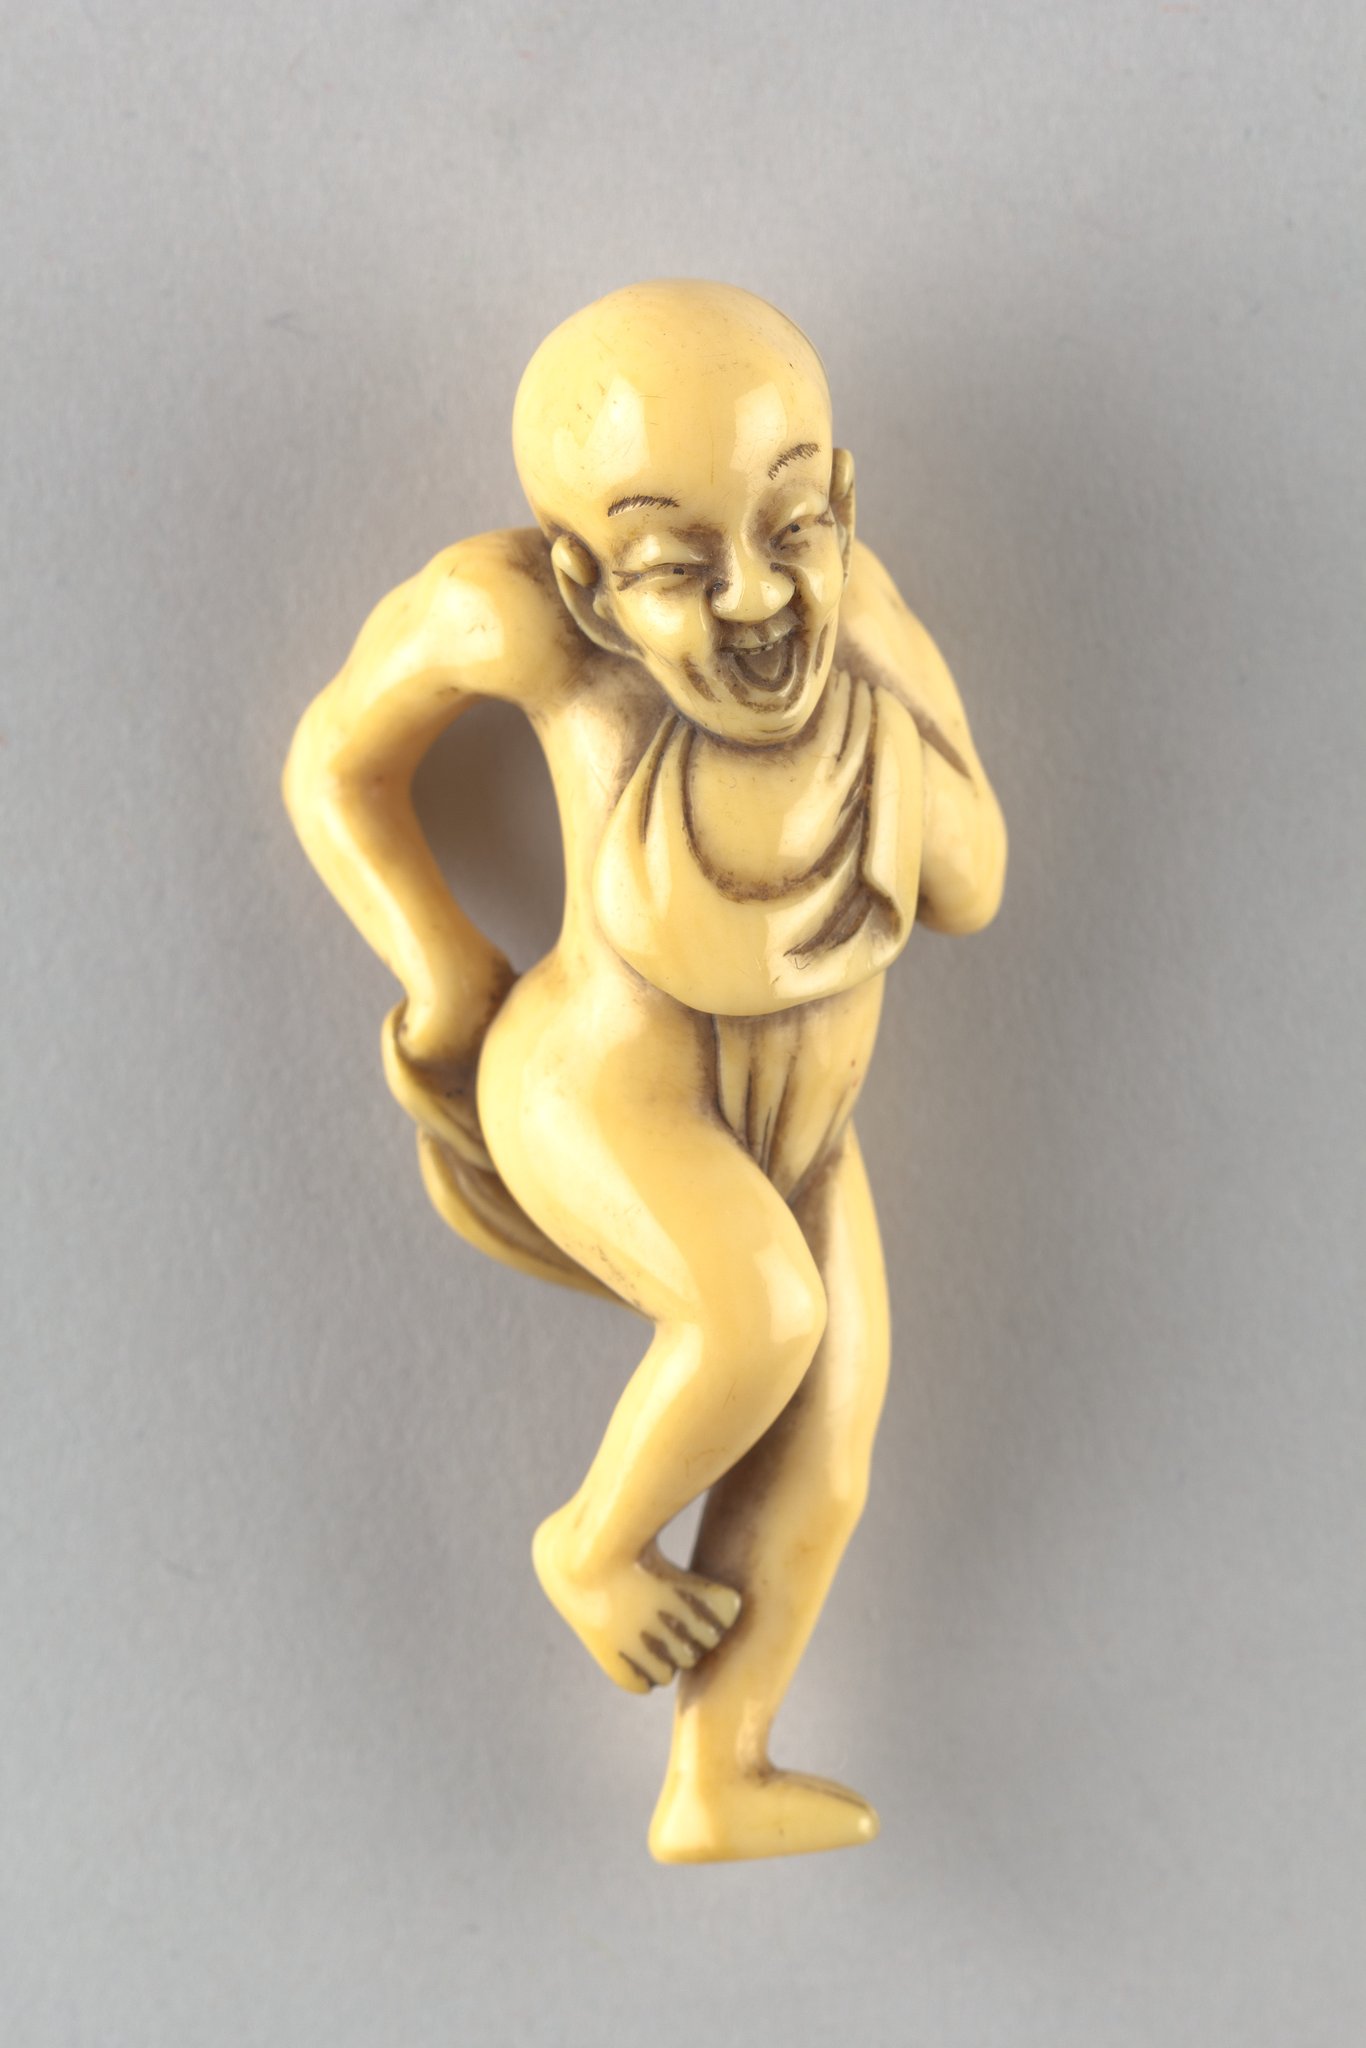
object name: netsuke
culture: japanese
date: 1701-1800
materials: ivory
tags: men